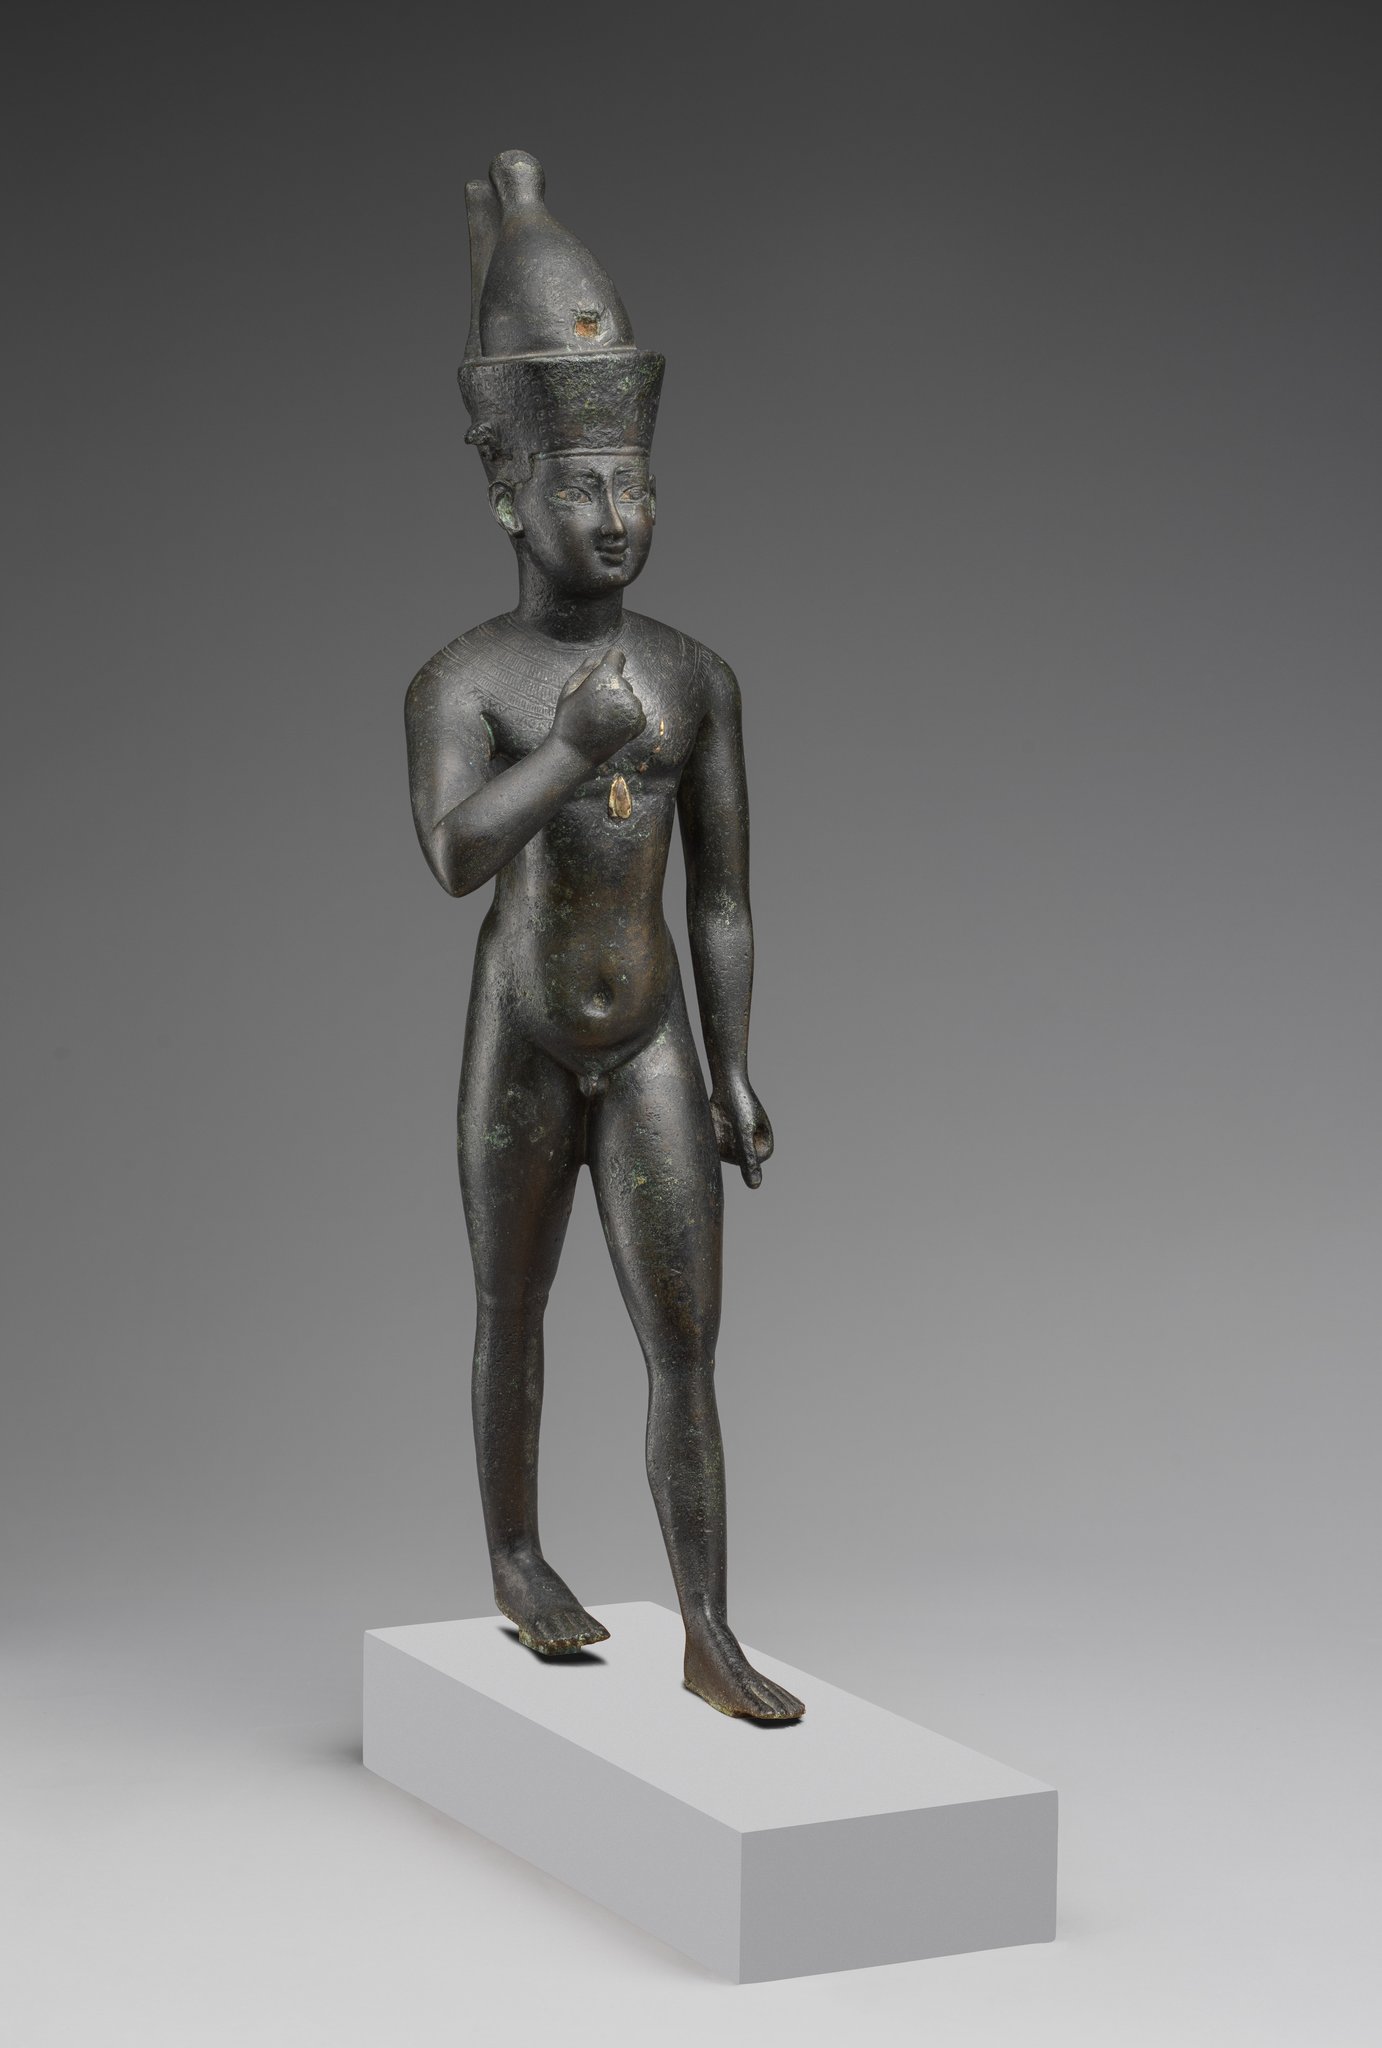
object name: statuette, harpokrates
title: Statuette of Horus the Child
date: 332-330 BCE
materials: metal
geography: eastern delta